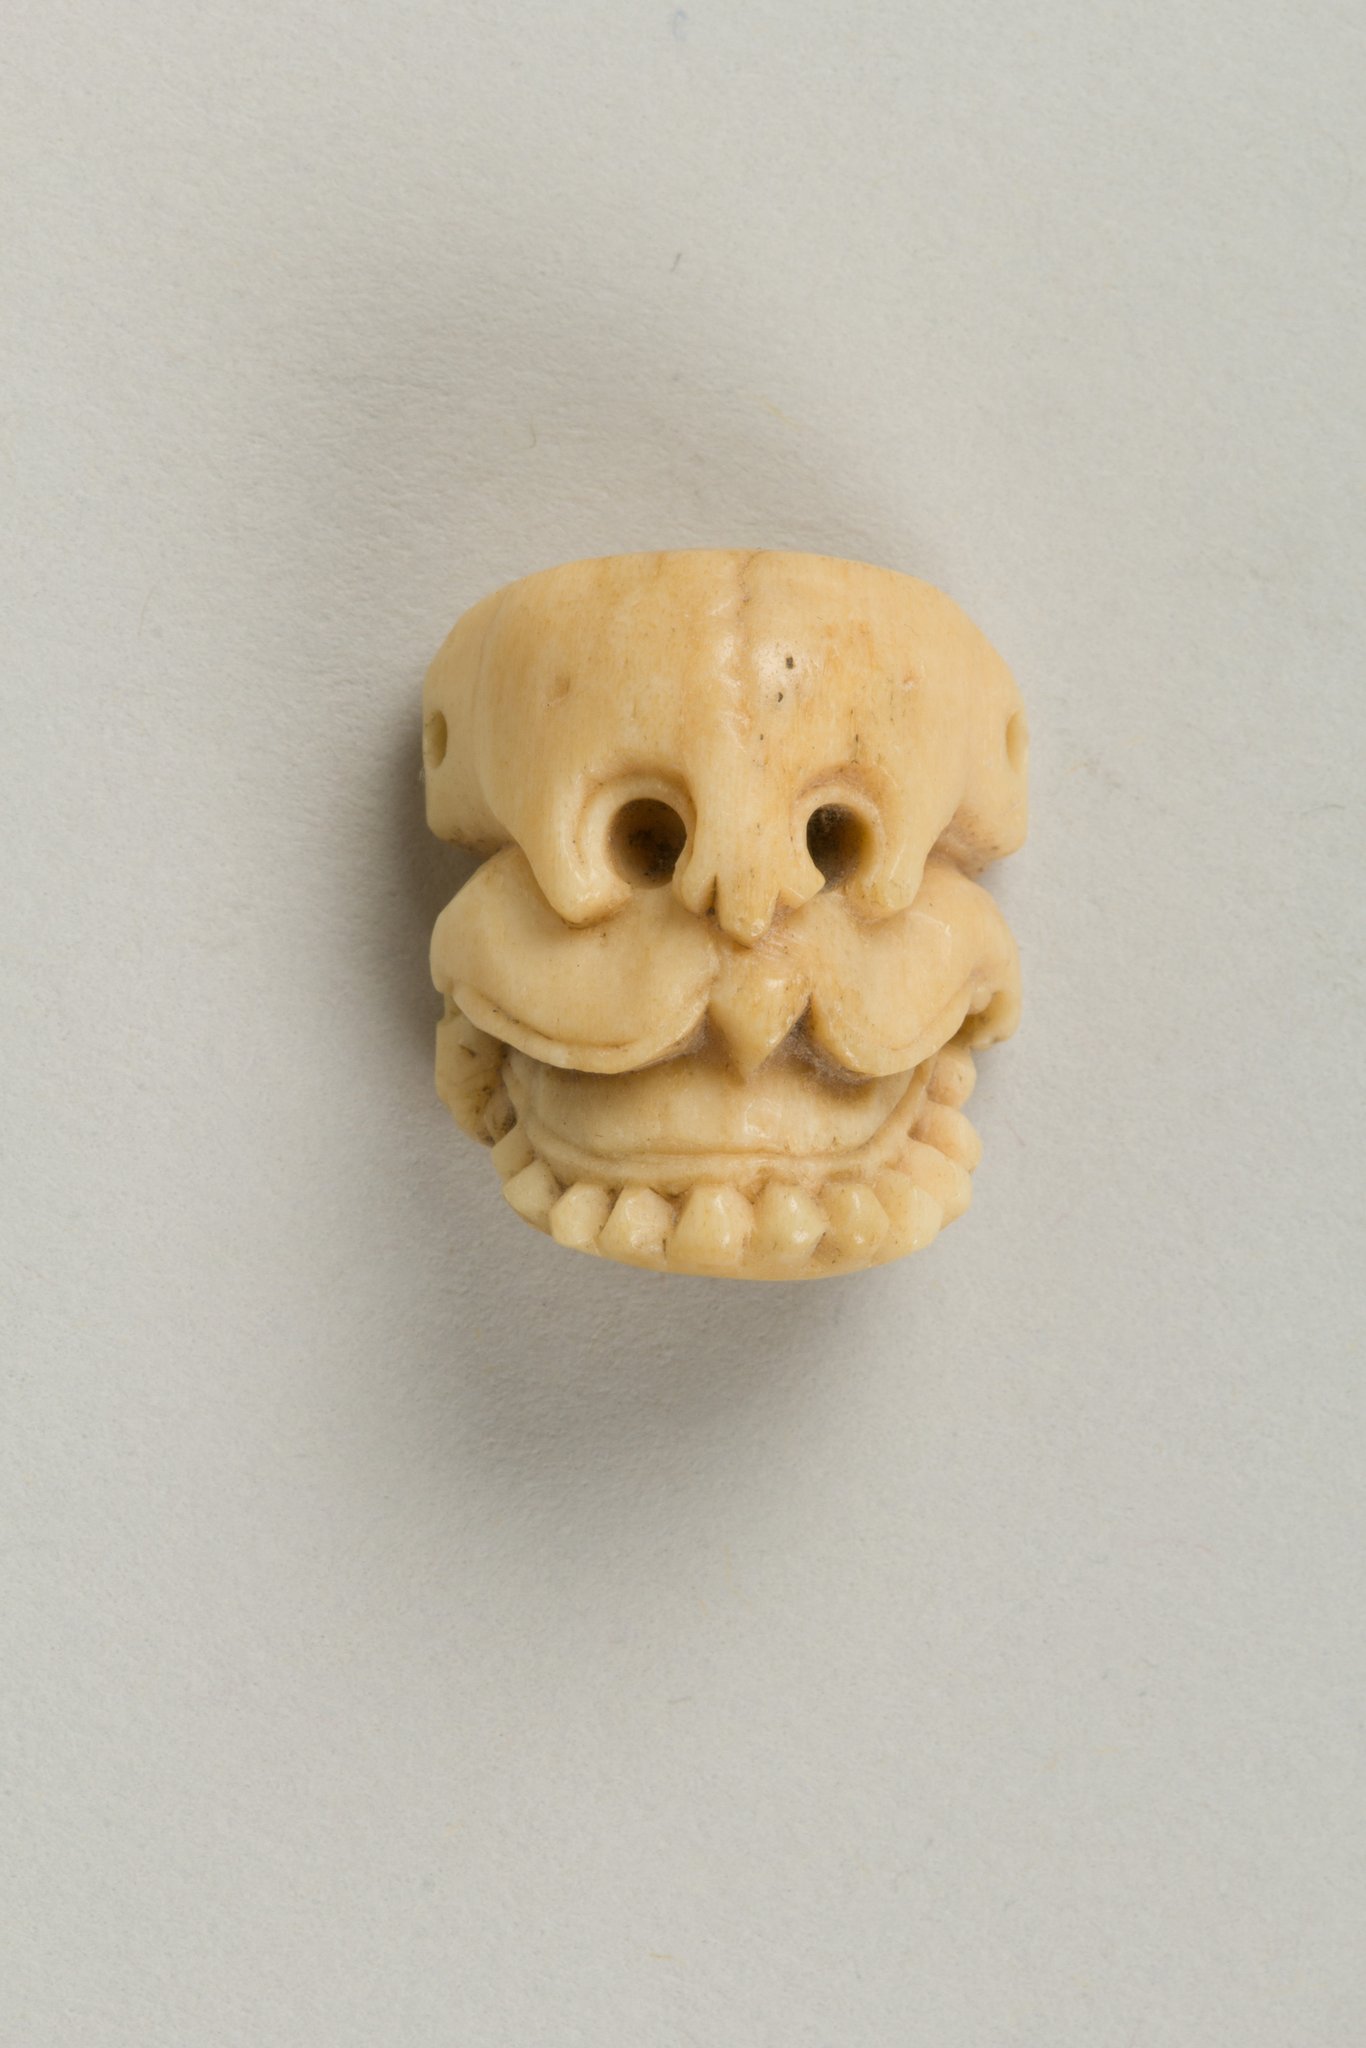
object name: ritual carving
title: Skull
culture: tibetan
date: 1501-1600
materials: bone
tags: skulls